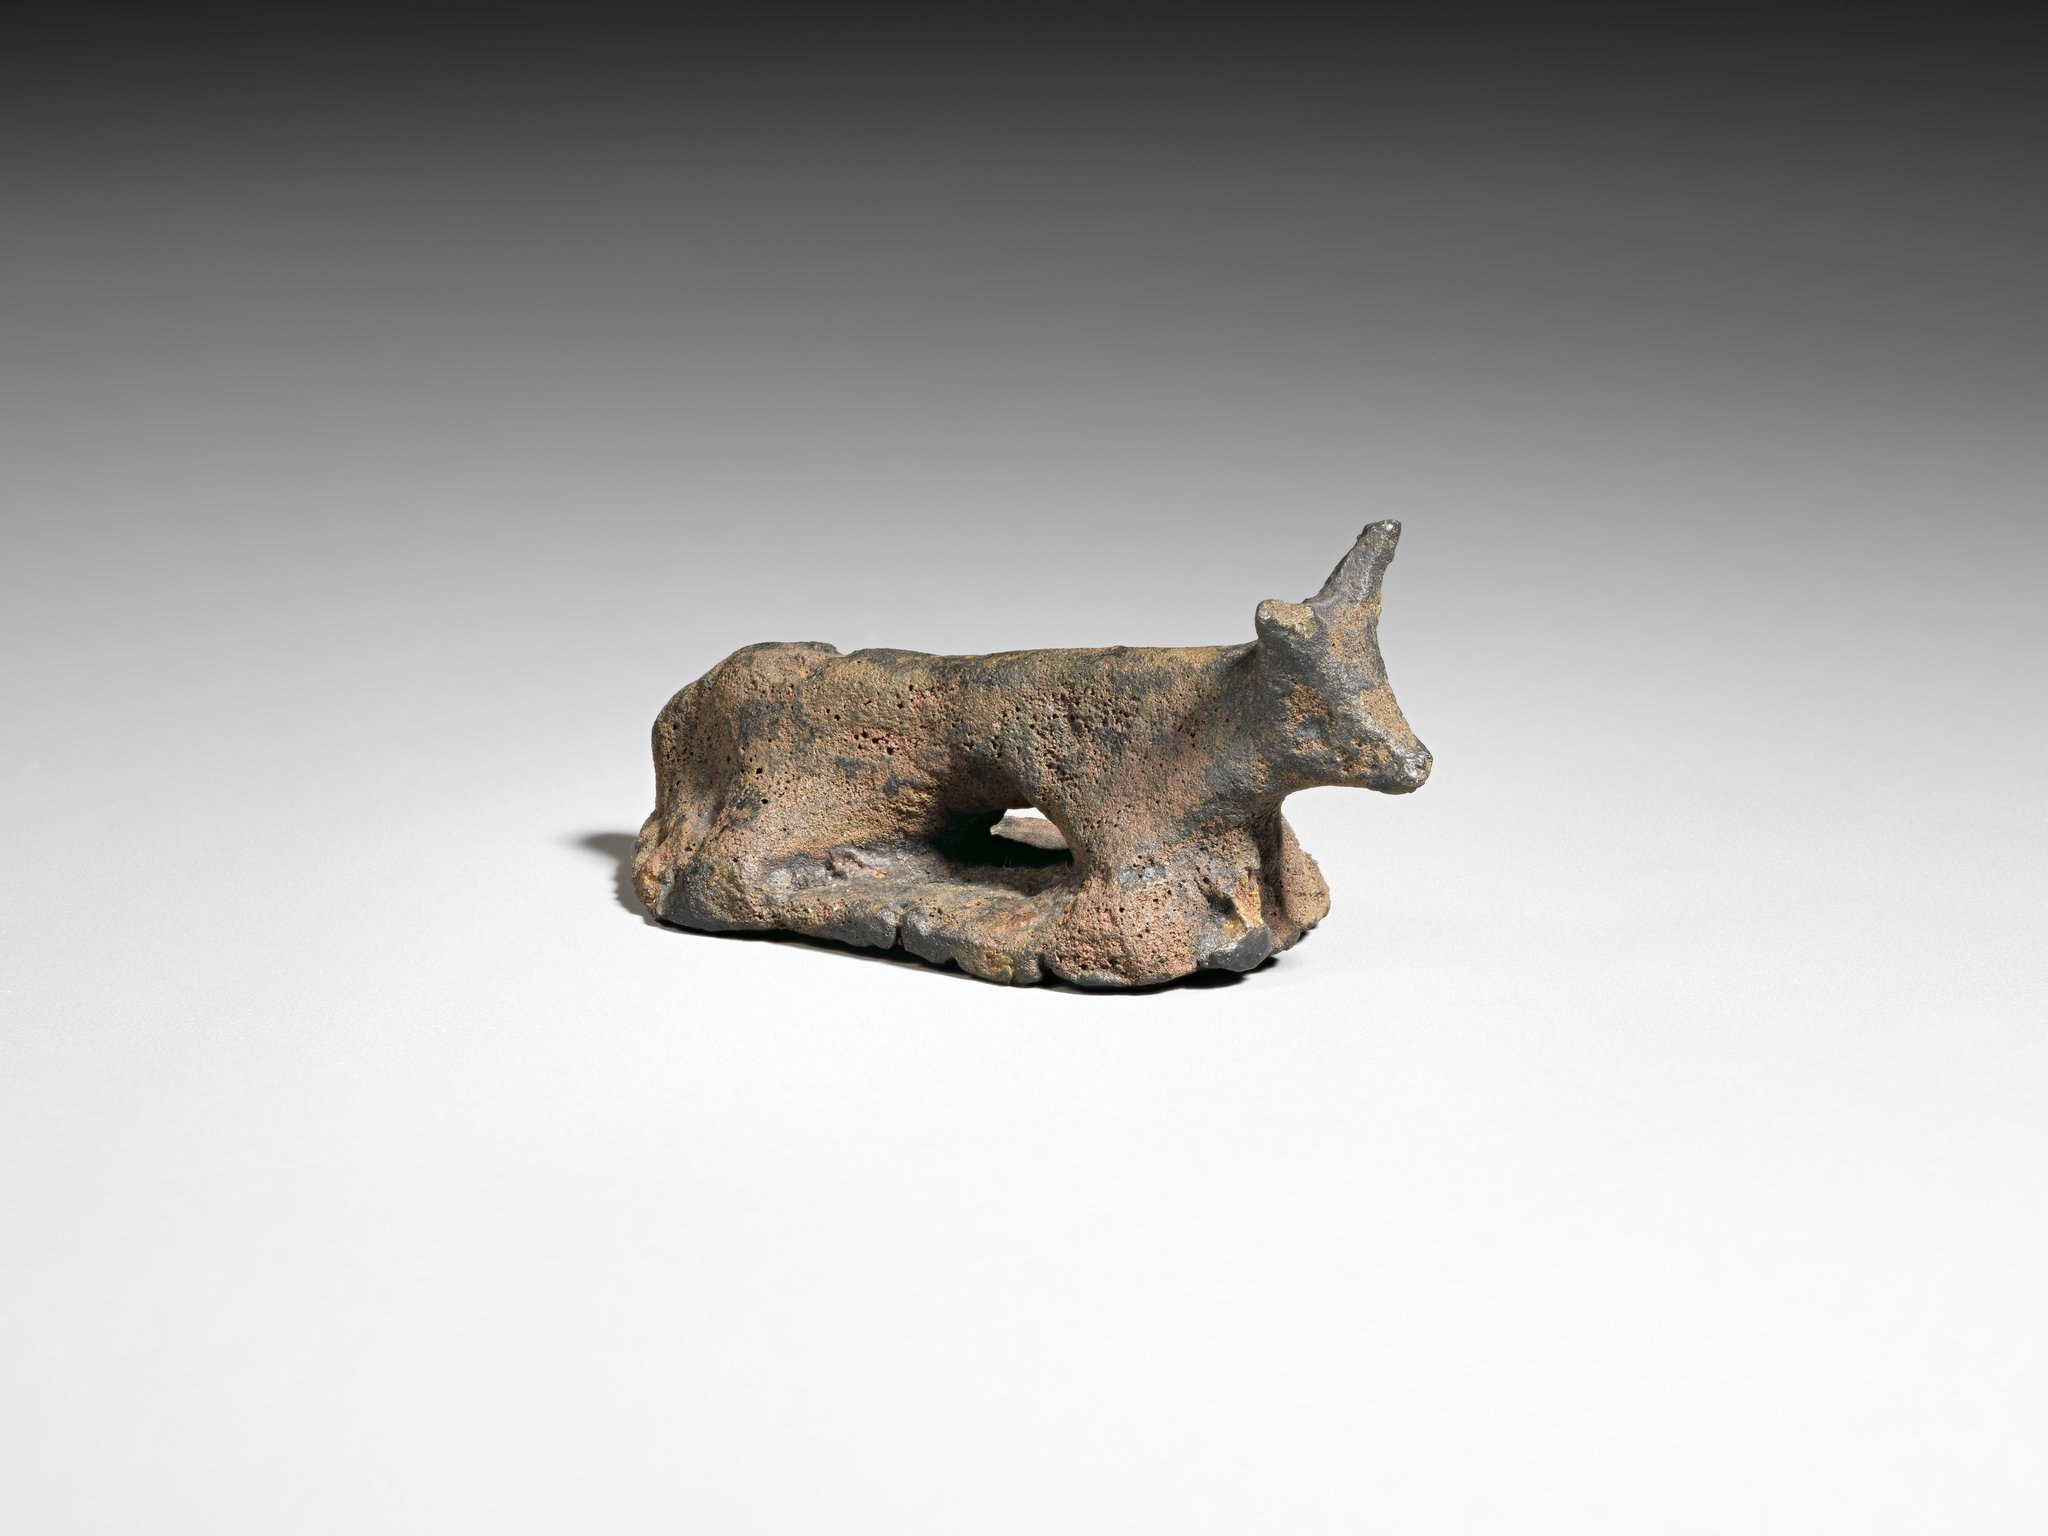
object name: sculpture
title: Dog figure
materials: bronze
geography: mesopotamia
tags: dogs